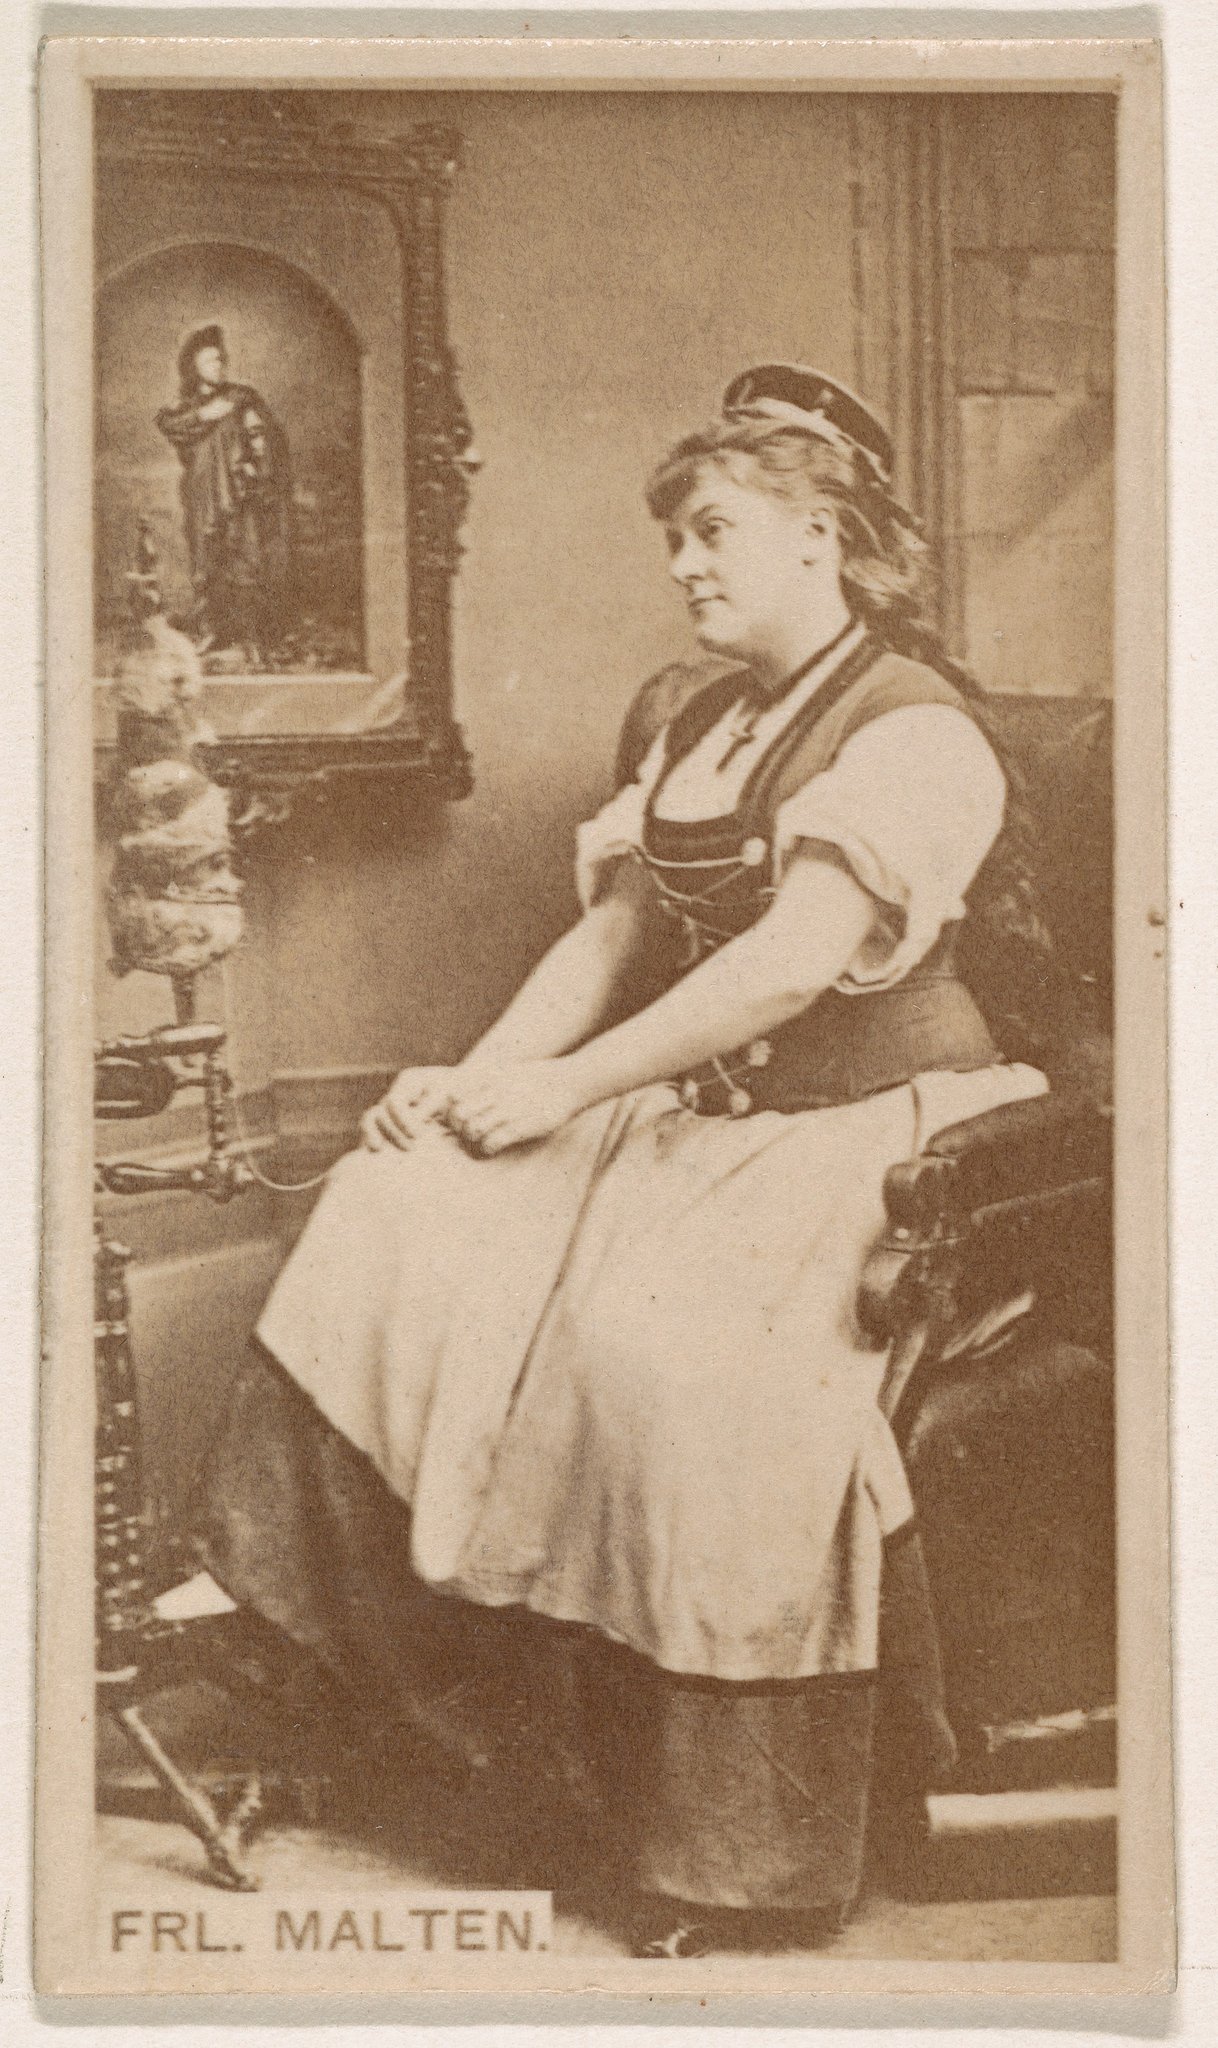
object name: photograph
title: Frl. Malten, from the Actresses series (N245) issued by Kinney Brothers to promote Sweet Caporal Cigarettes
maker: kinney brothers tobacco company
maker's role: publisher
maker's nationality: american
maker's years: 1869-2011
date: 1890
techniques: albumen silver print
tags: women,actresses